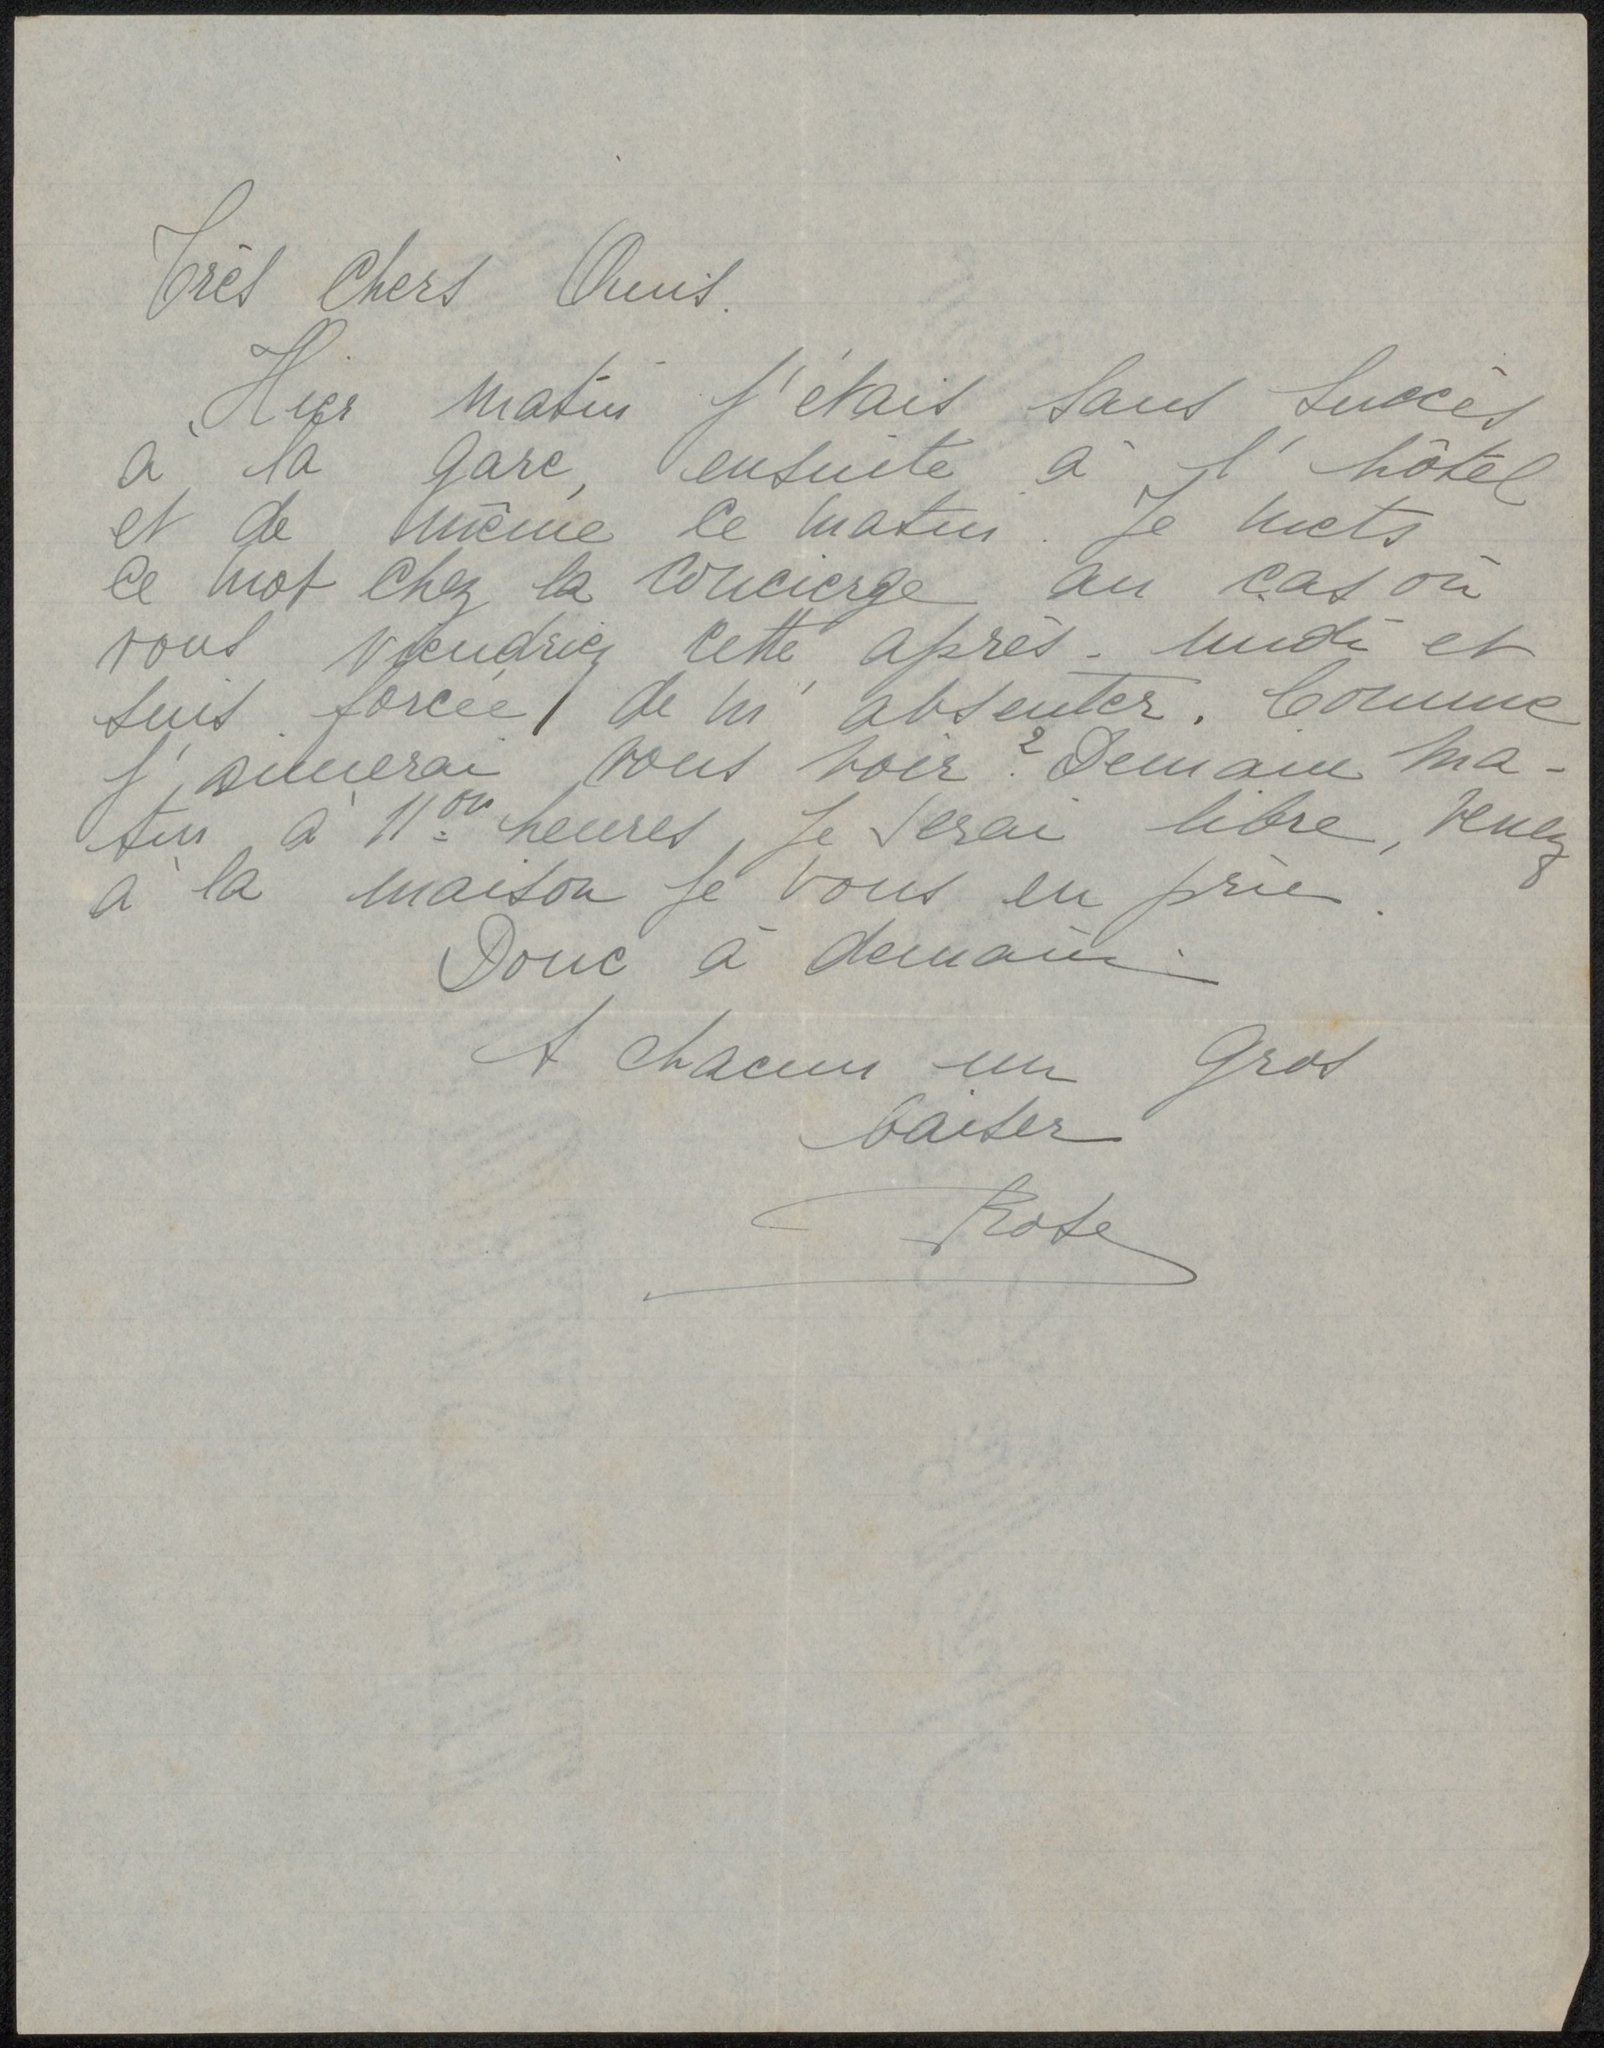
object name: letter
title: Brief aan Philip Zilcken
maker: rose imel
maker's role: draughtsman, painter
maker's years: 1901-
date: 1911-1930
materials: ink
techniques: pen, writing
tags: painter, draughtsman, philip zilcken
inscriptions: watermark, collector's mark: ‘RPK’